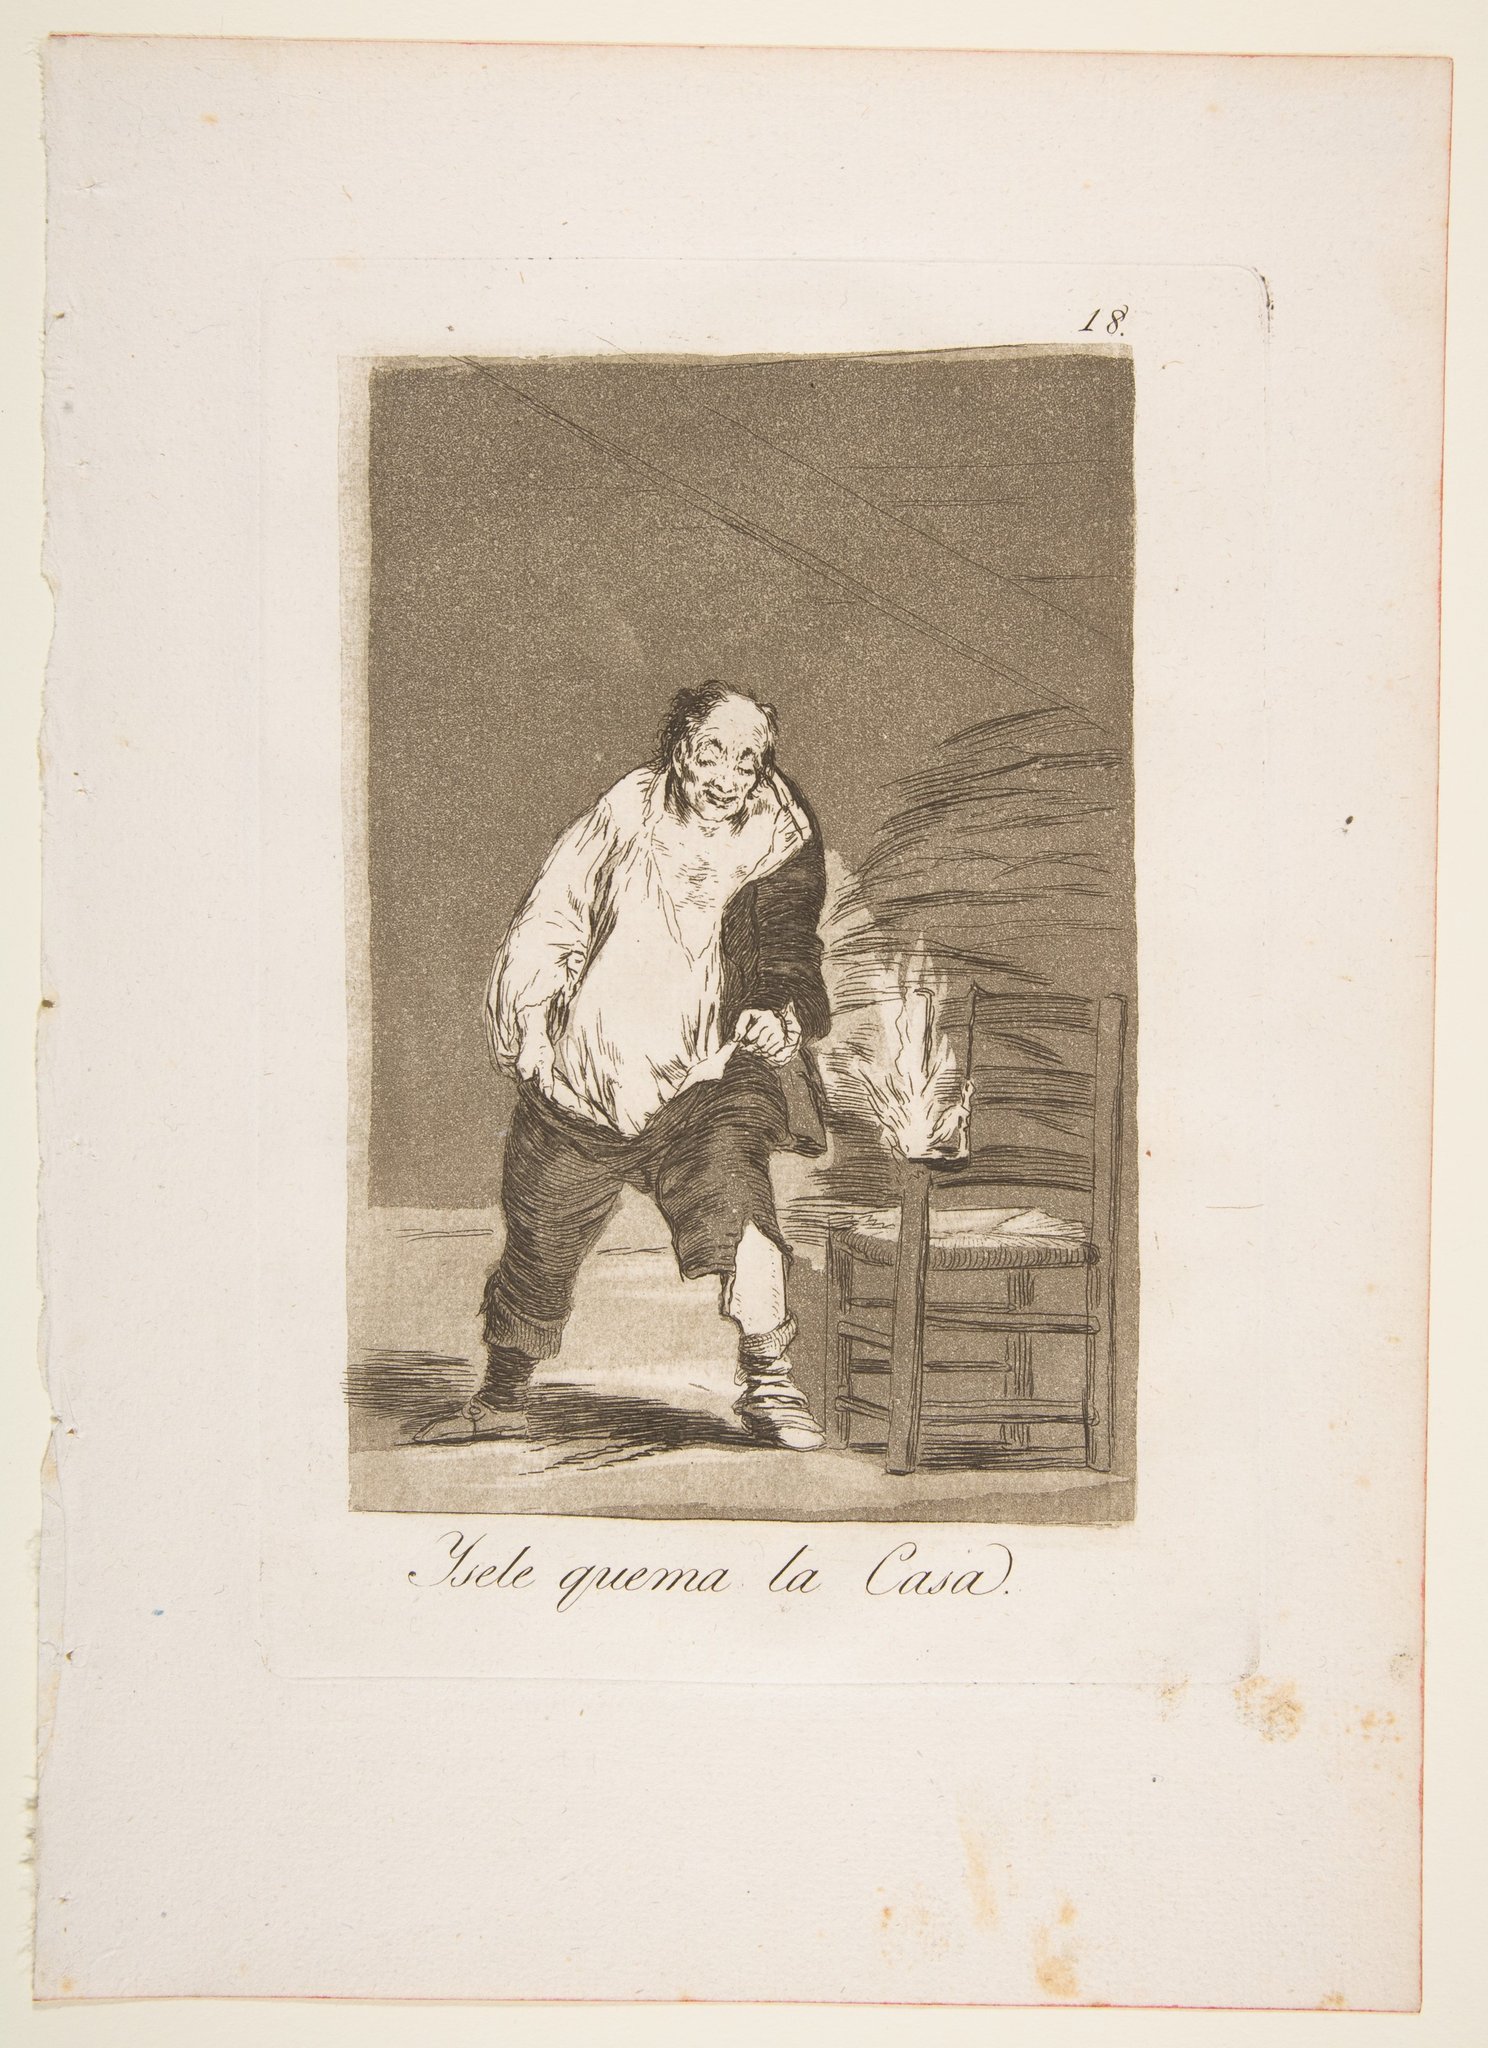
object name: print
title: Plate 18 from "Los Caprichos": And his house is on fire (Ysele quema la Casa)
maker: goya (francisco de goya y lucientes)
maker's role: artist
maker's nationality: spanish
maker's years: 1746-1828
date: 1799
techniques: aquatint, burnishing, etching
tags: men,fire,chairs